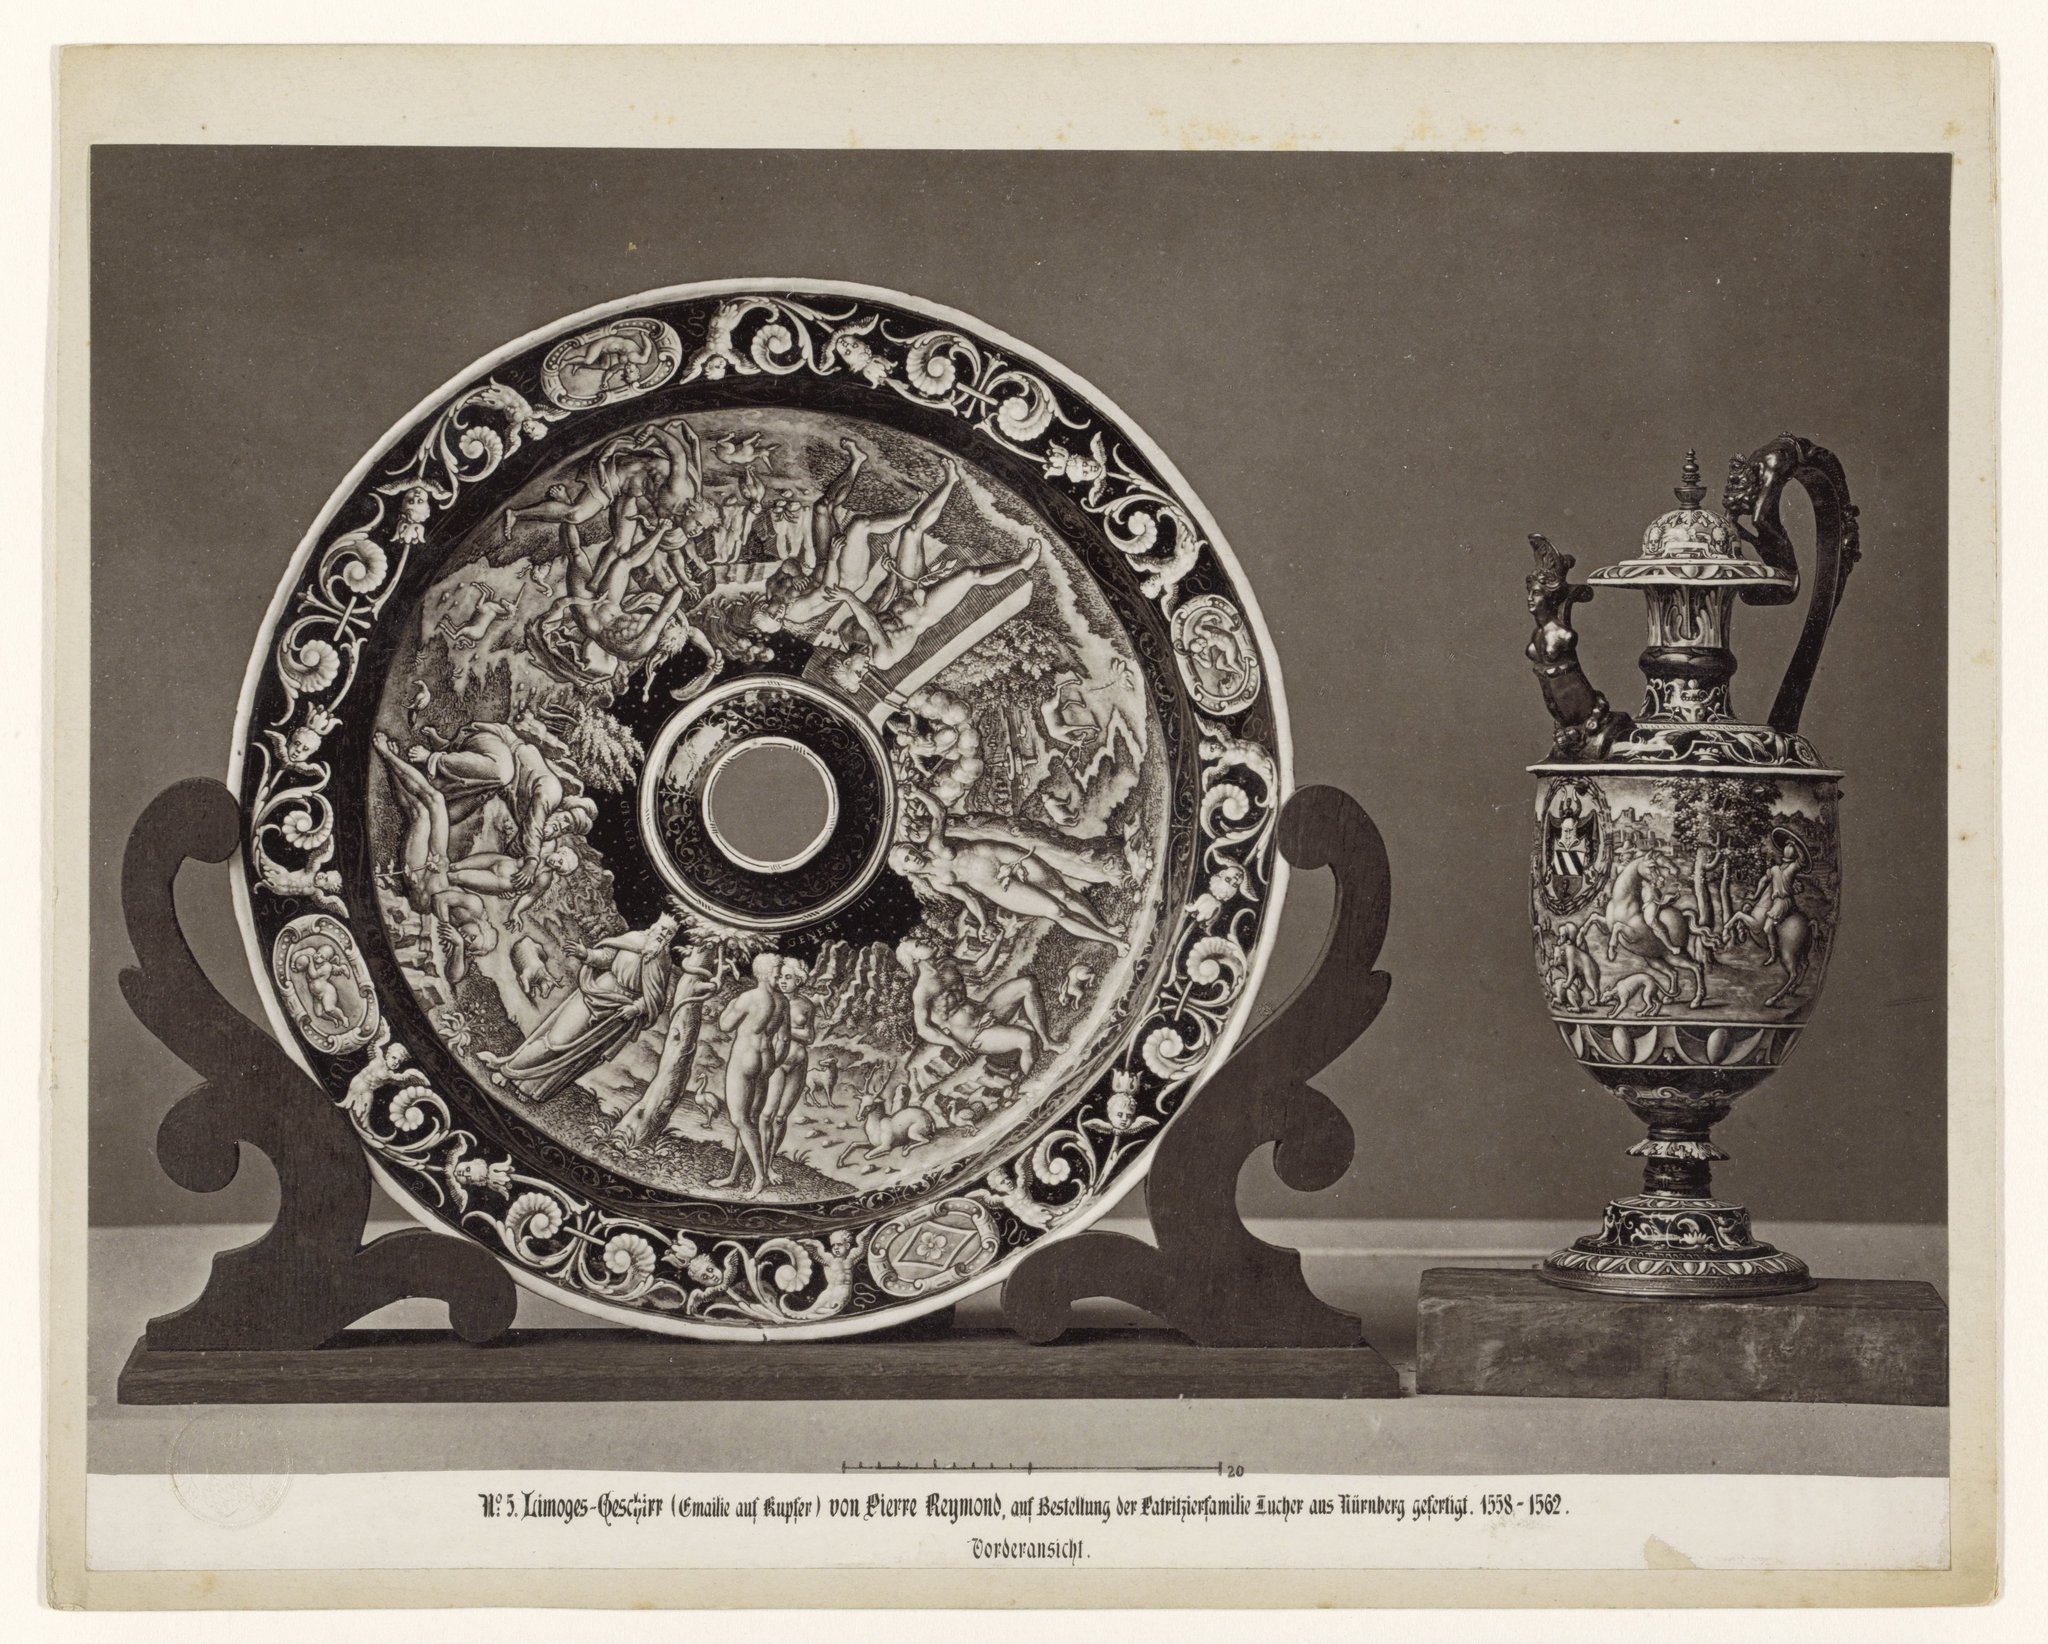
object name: photomechanical print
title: Limoges-servies van Pierre Raymond, vooraanzicht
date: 1869-1887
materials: cardboard, paper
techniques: photograph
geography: munich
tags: container of ceramics: jar, jug, pot, vase, dish, plate, saucer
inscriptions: check stamp: ‘Bayerisches National-Museum’, title: ‘No 5. Limoges-Geschirr (Emaille auf Kupfer) von Pierre Reymond, auf Bestellung der Patrizierfamilie Zucher aus Nurnberg gefertigt. 1558-1562./ Vorderansicht.’